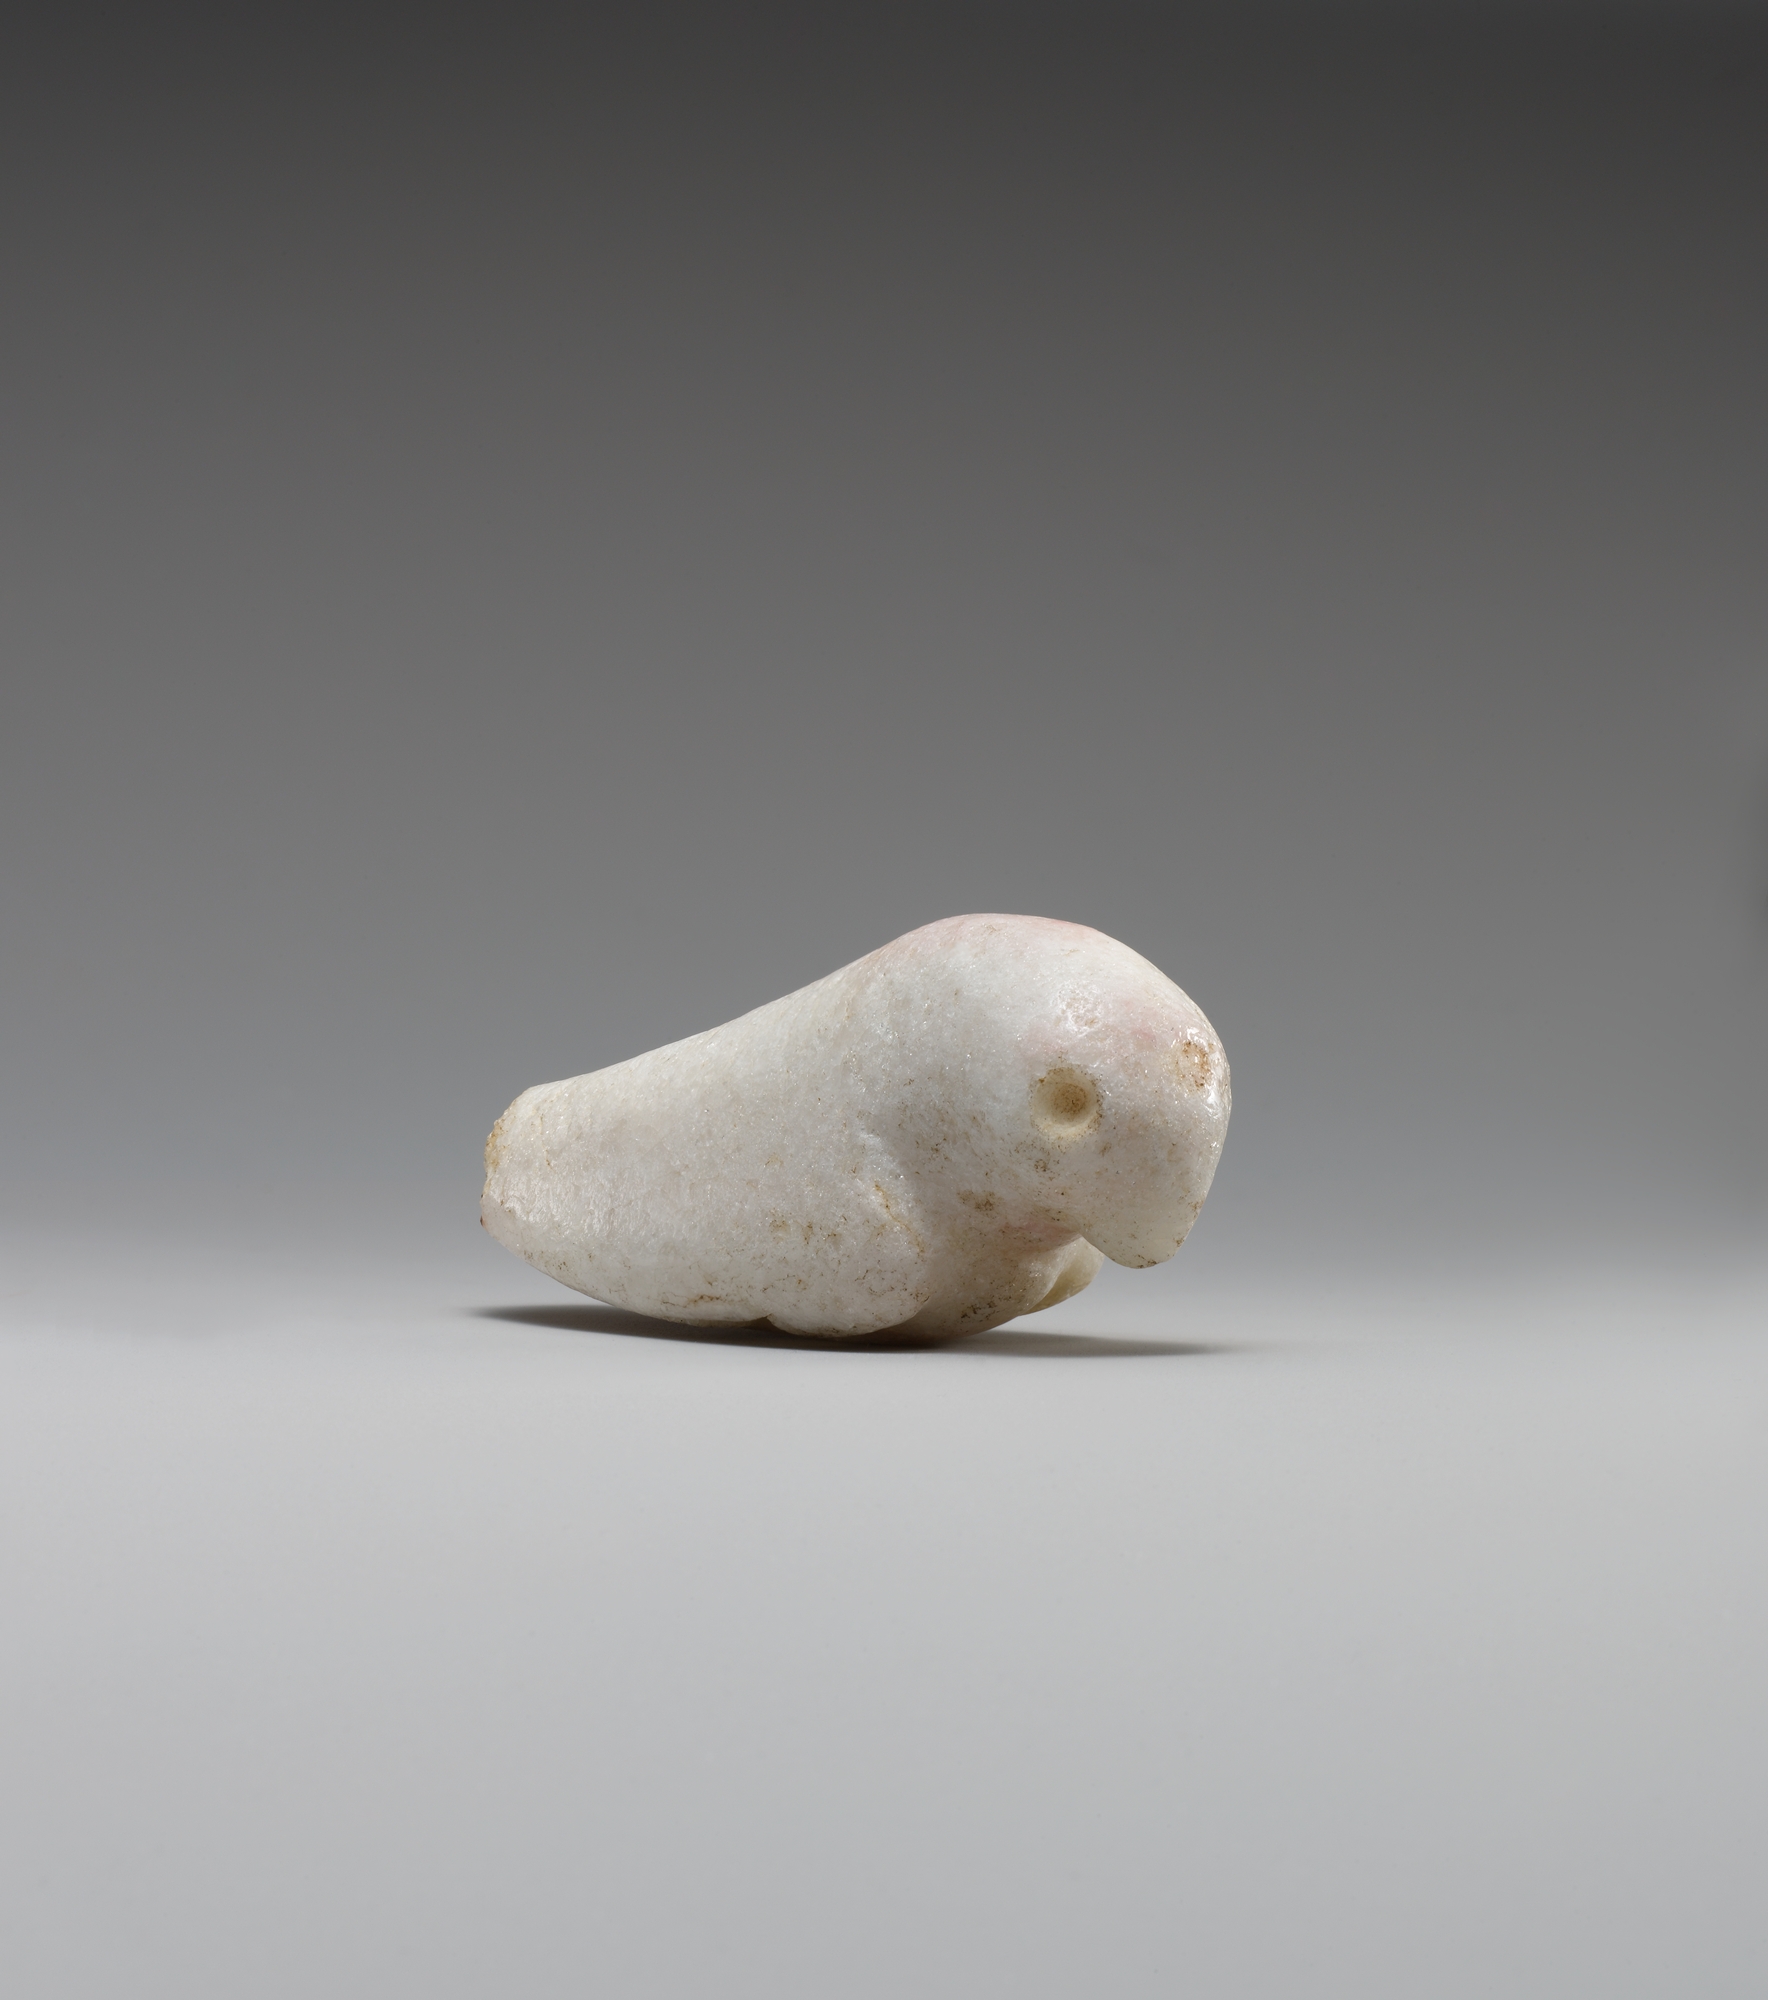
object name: figurine, falcon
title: Falcon Figurine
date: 3300-2900 BCE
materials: quartzite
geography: egypt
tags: falcons